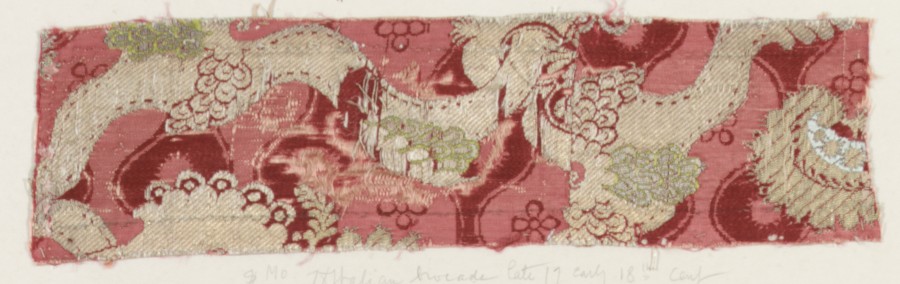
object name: fragment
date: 1701-1733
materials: metal thread, silk